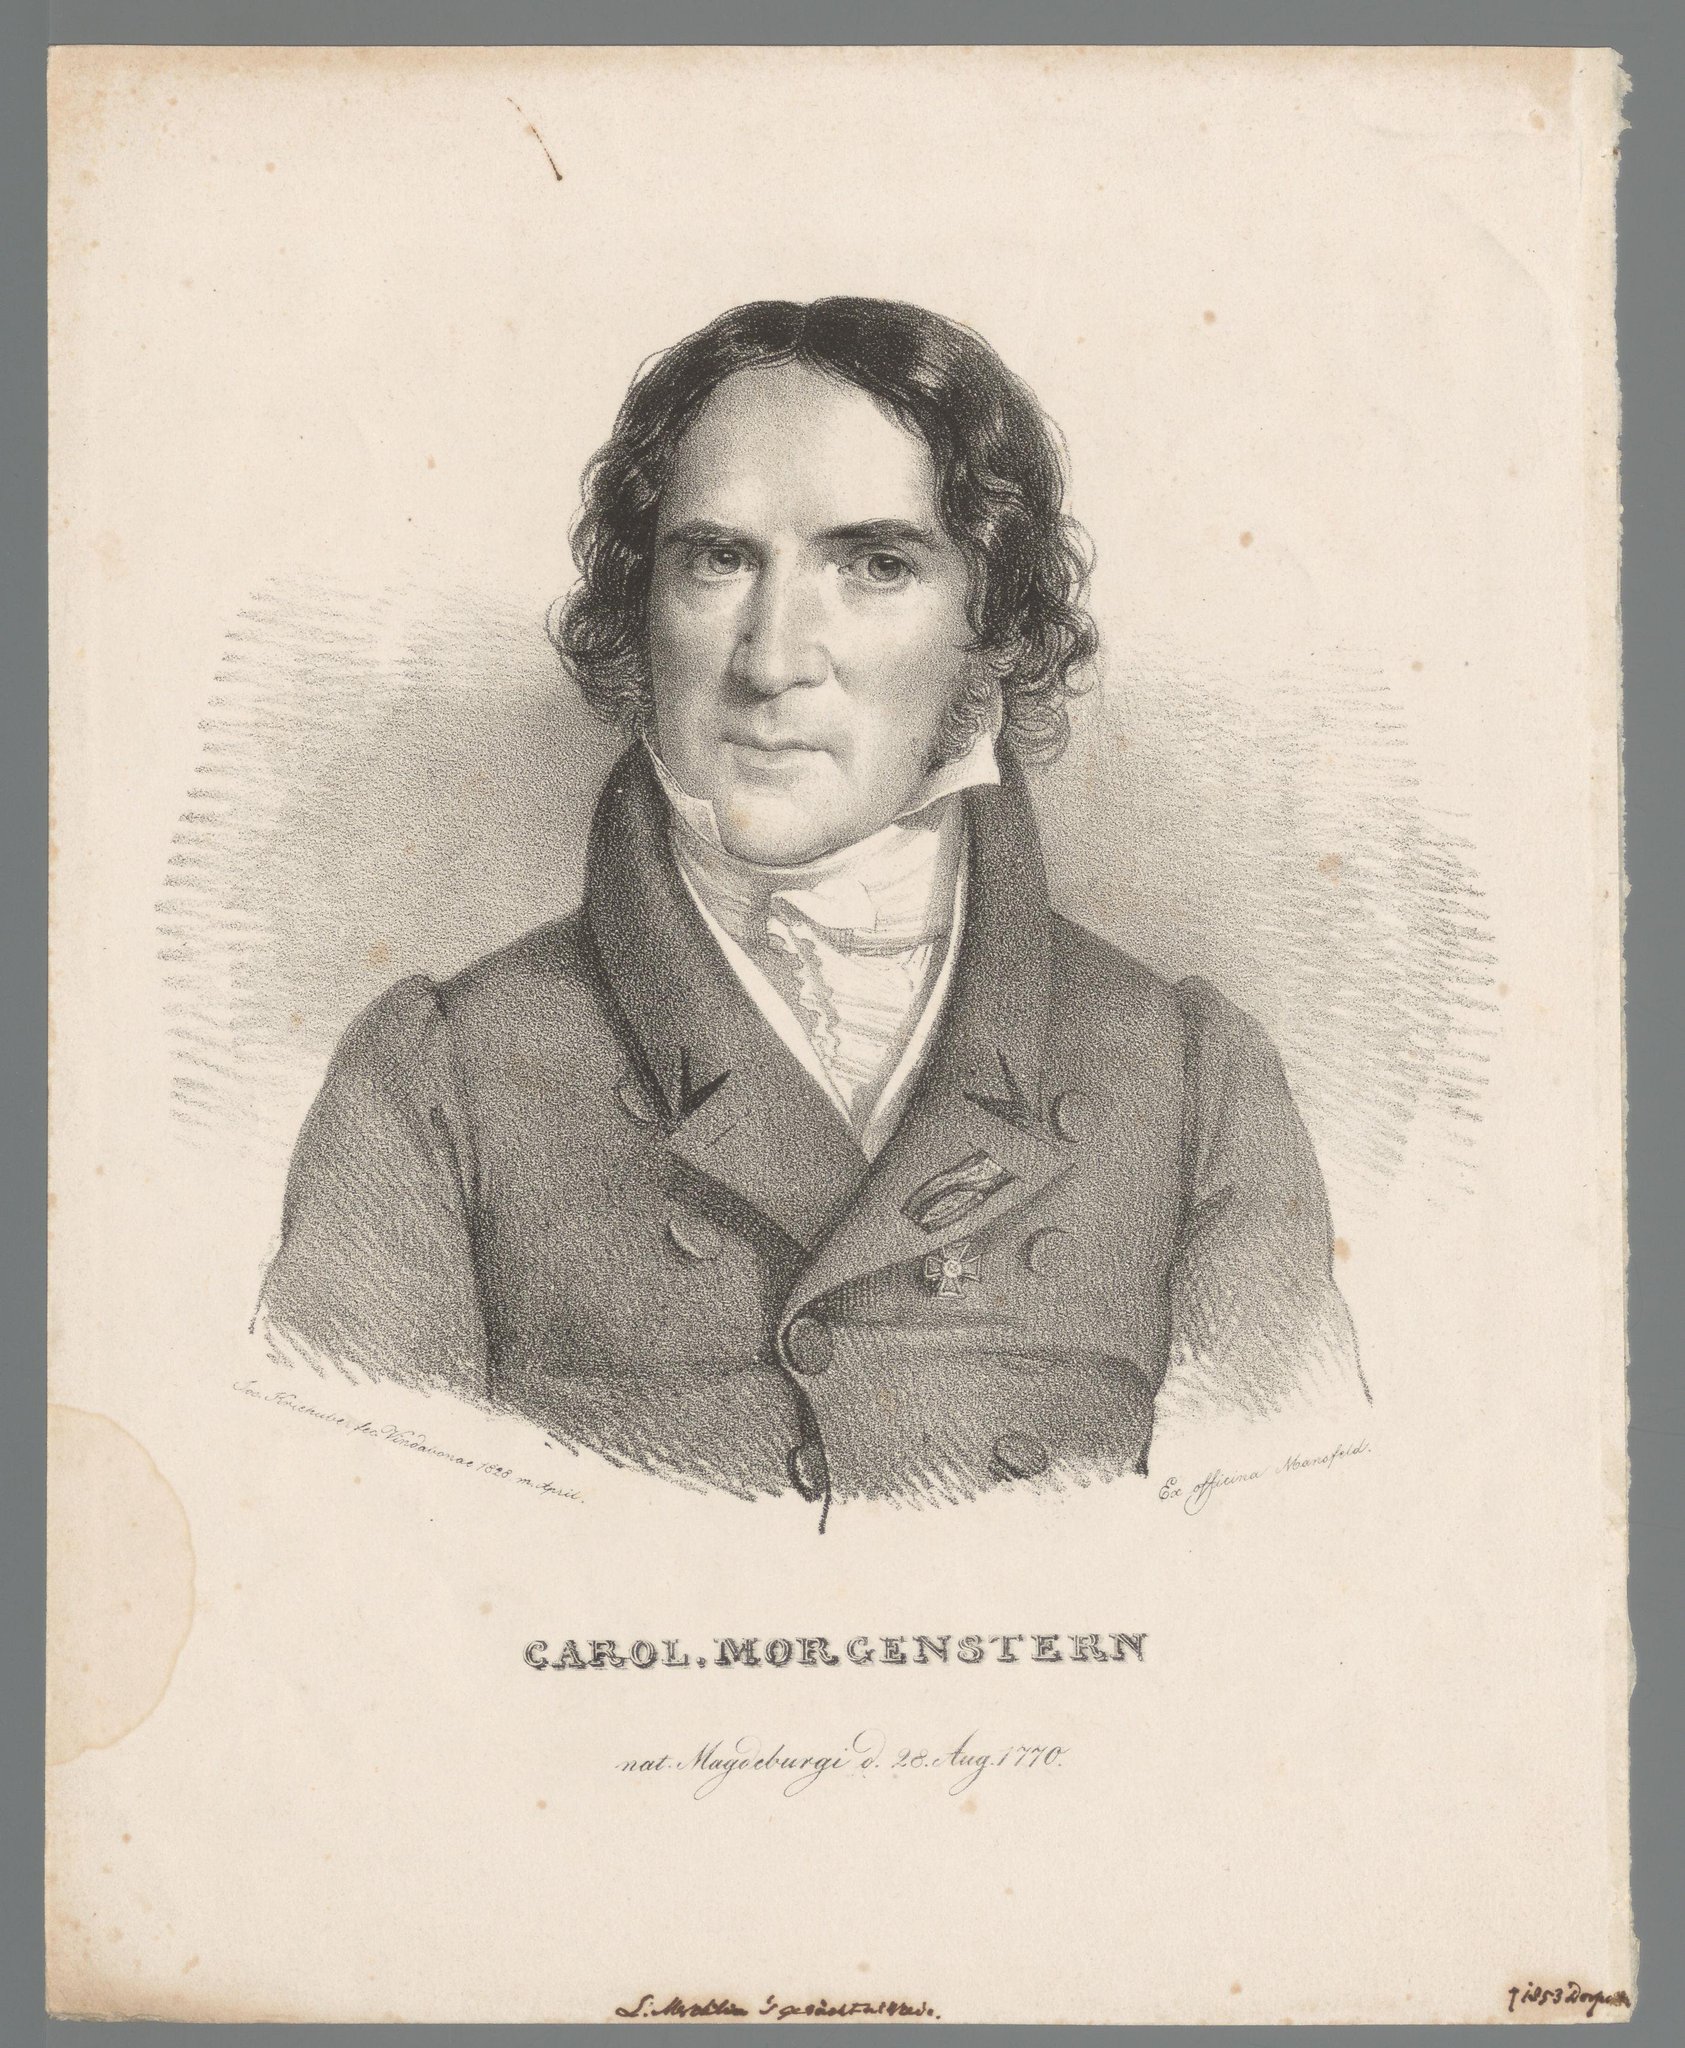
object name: print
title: Portret van Karl Simon Morgenstern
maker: josef kriehuber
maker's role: painter, print maker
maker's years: 1800-1876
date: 1828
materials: paper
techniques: lithograph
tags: philology, historical persons, public library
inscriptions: collector's mark: Lugt 2228